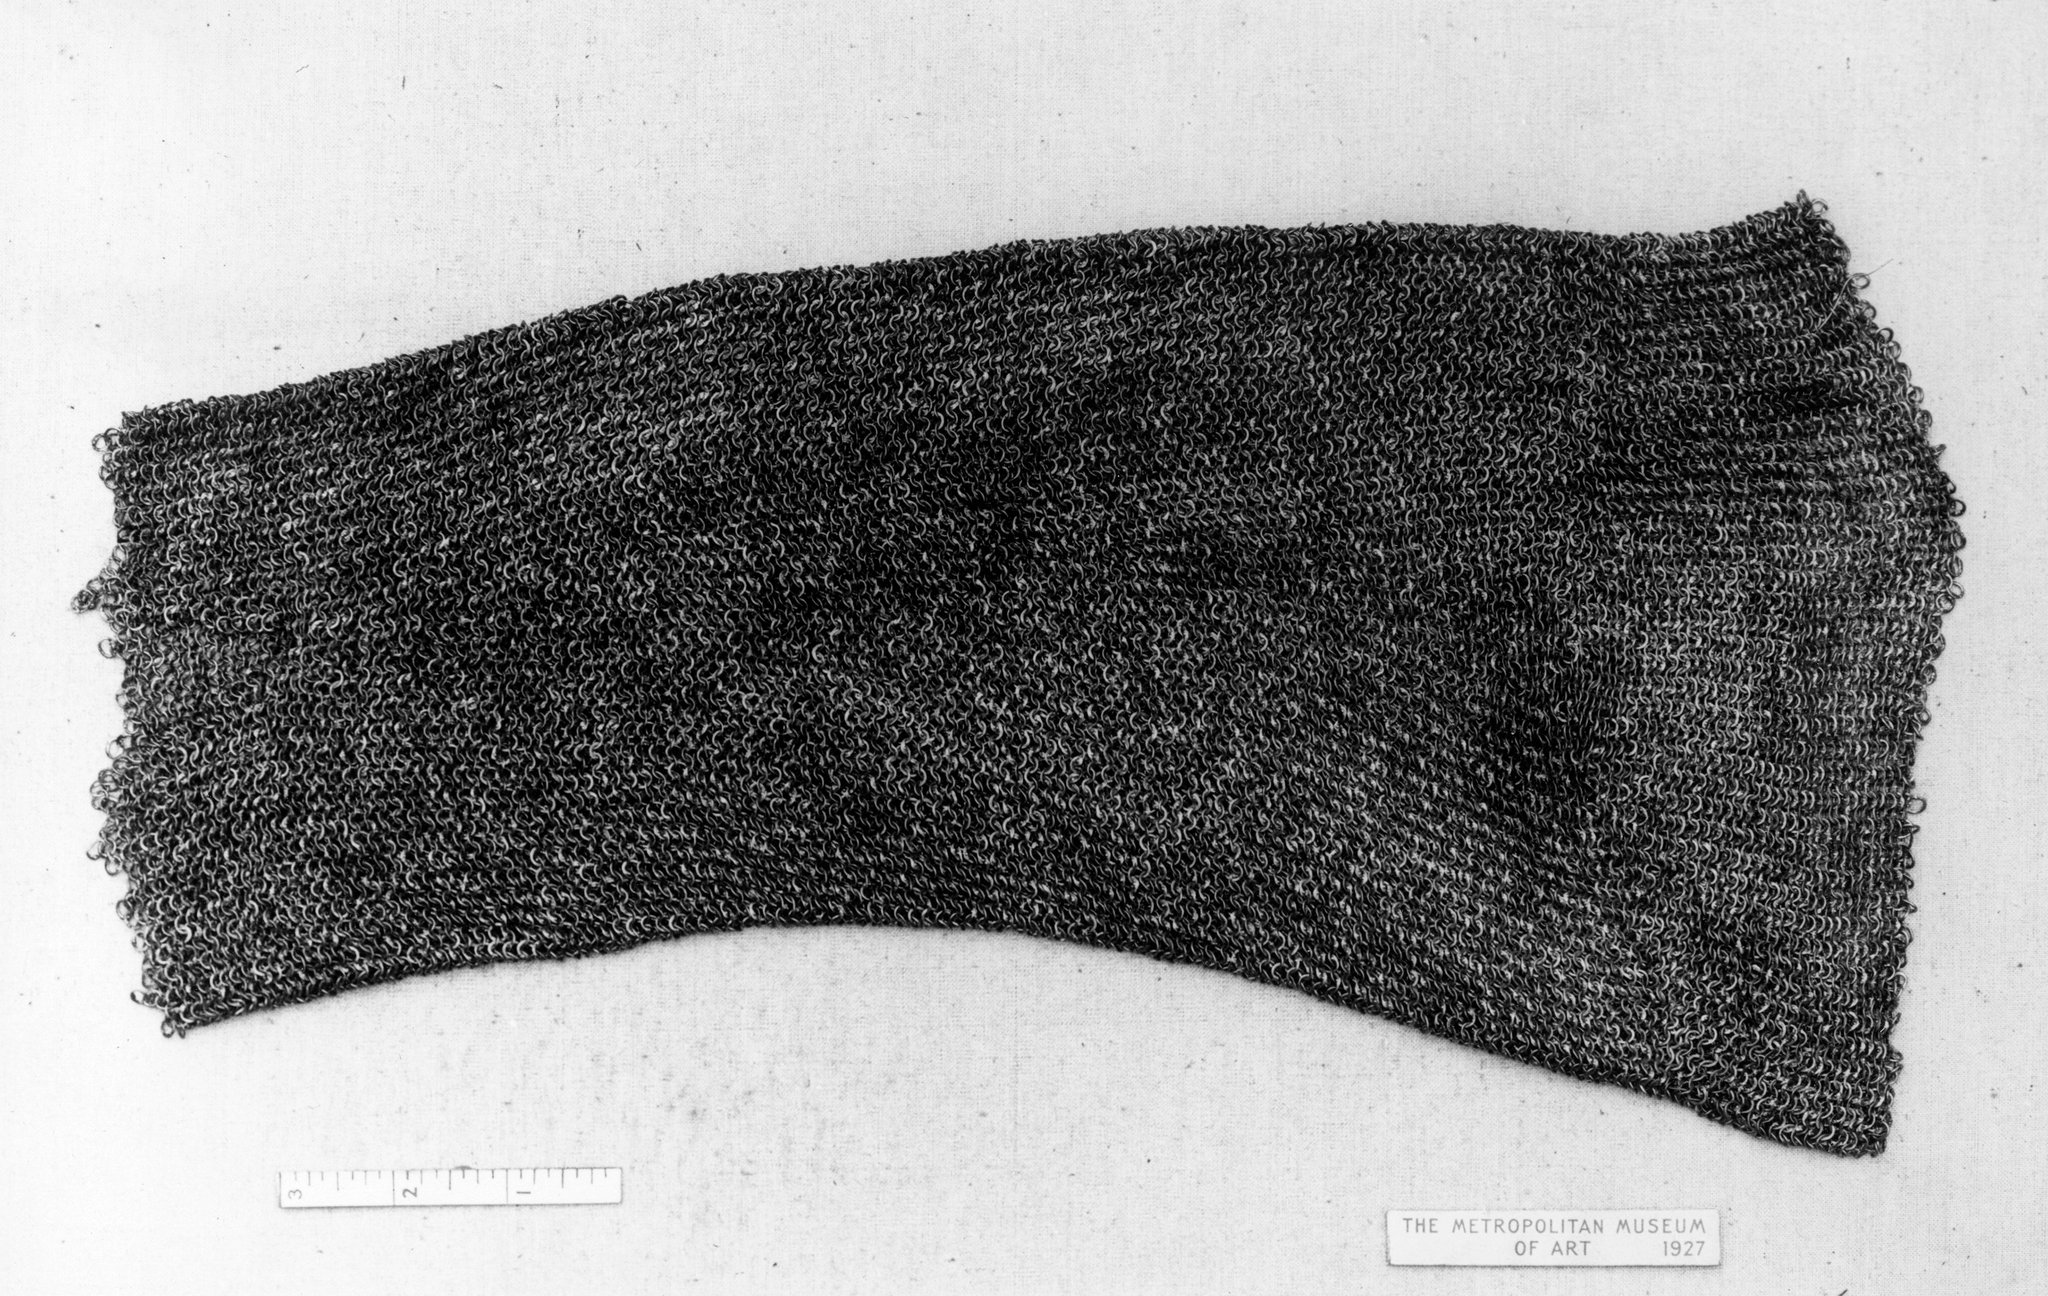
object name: sleeve of mail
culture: german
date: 1501-1600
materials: steel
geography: germany